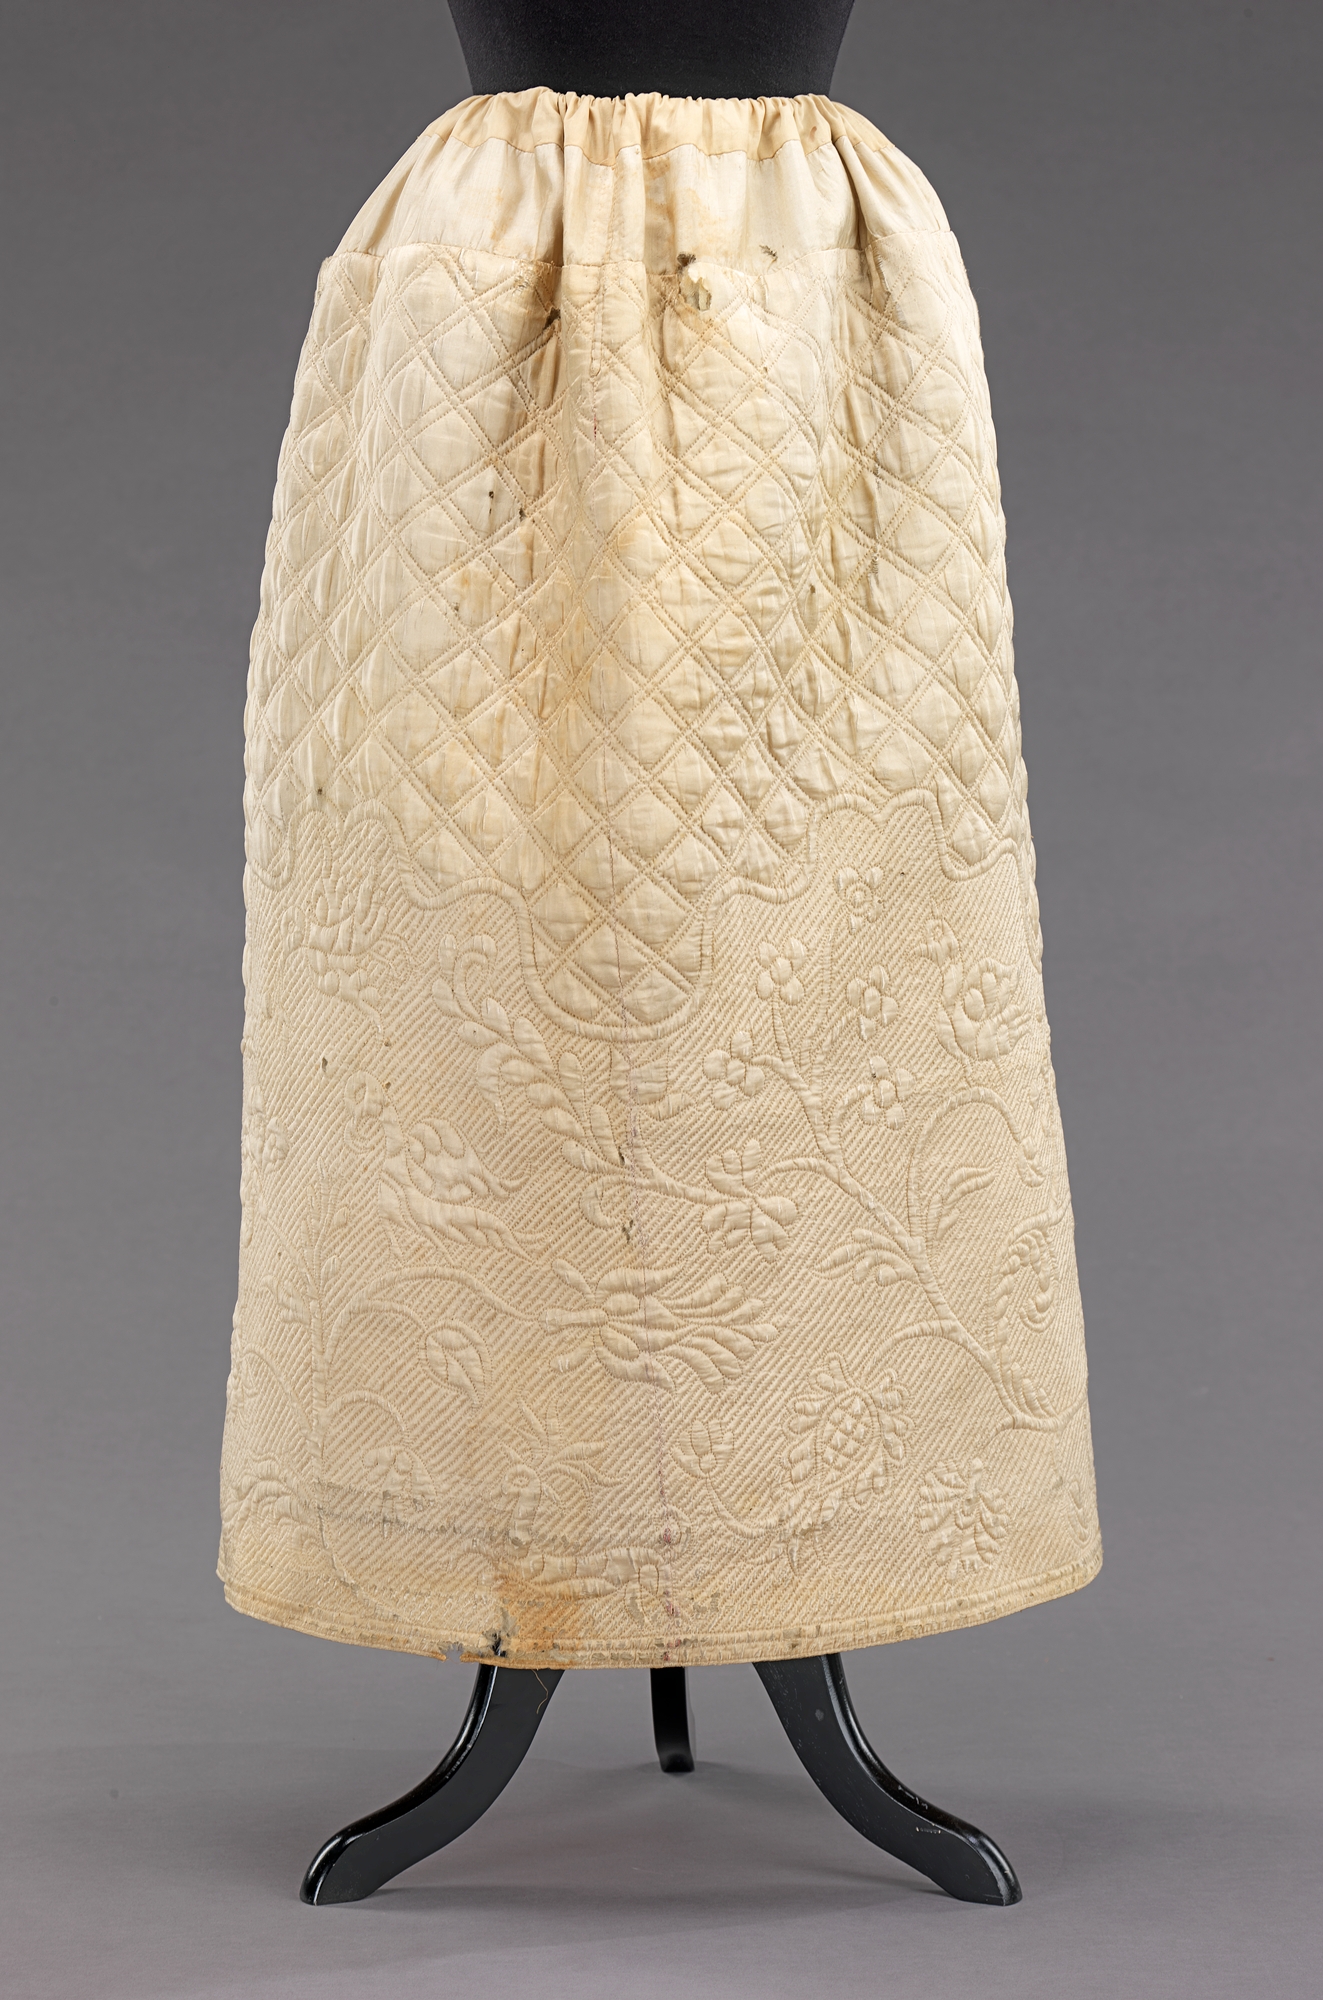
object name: wedding petticoat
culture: american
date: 1776-1800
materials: silk